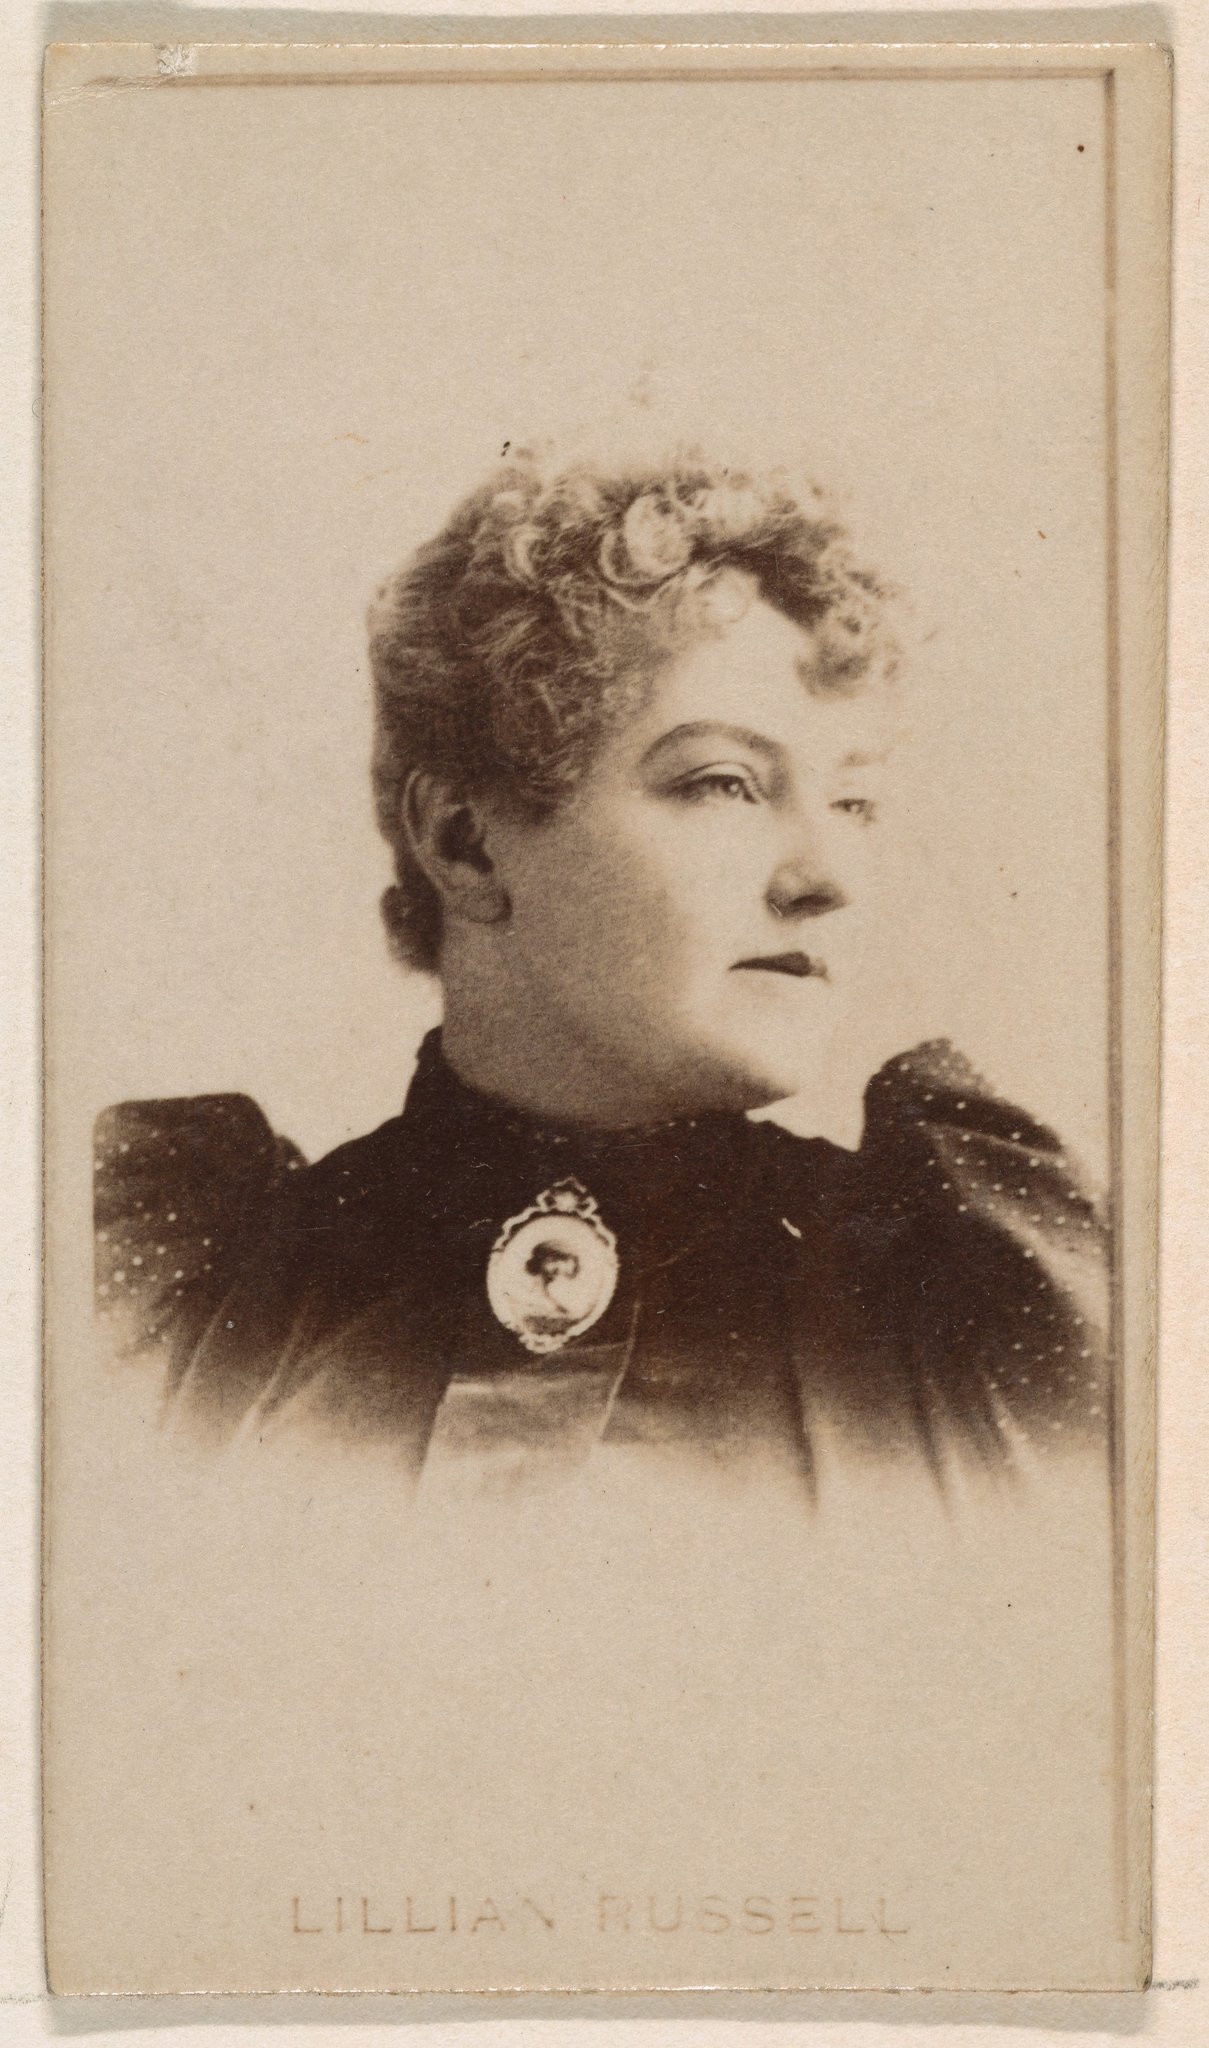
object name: photograph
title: Lillian Russell, from the Actresses series (N245) issued by Kinney Brothers to promote Sweet Caporal Cigarettes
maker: kinney brothers tobacco company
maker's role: publisher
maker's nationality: american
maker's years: 1869-2011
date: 1890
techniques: albumen silver print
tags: portraits,women,actresses